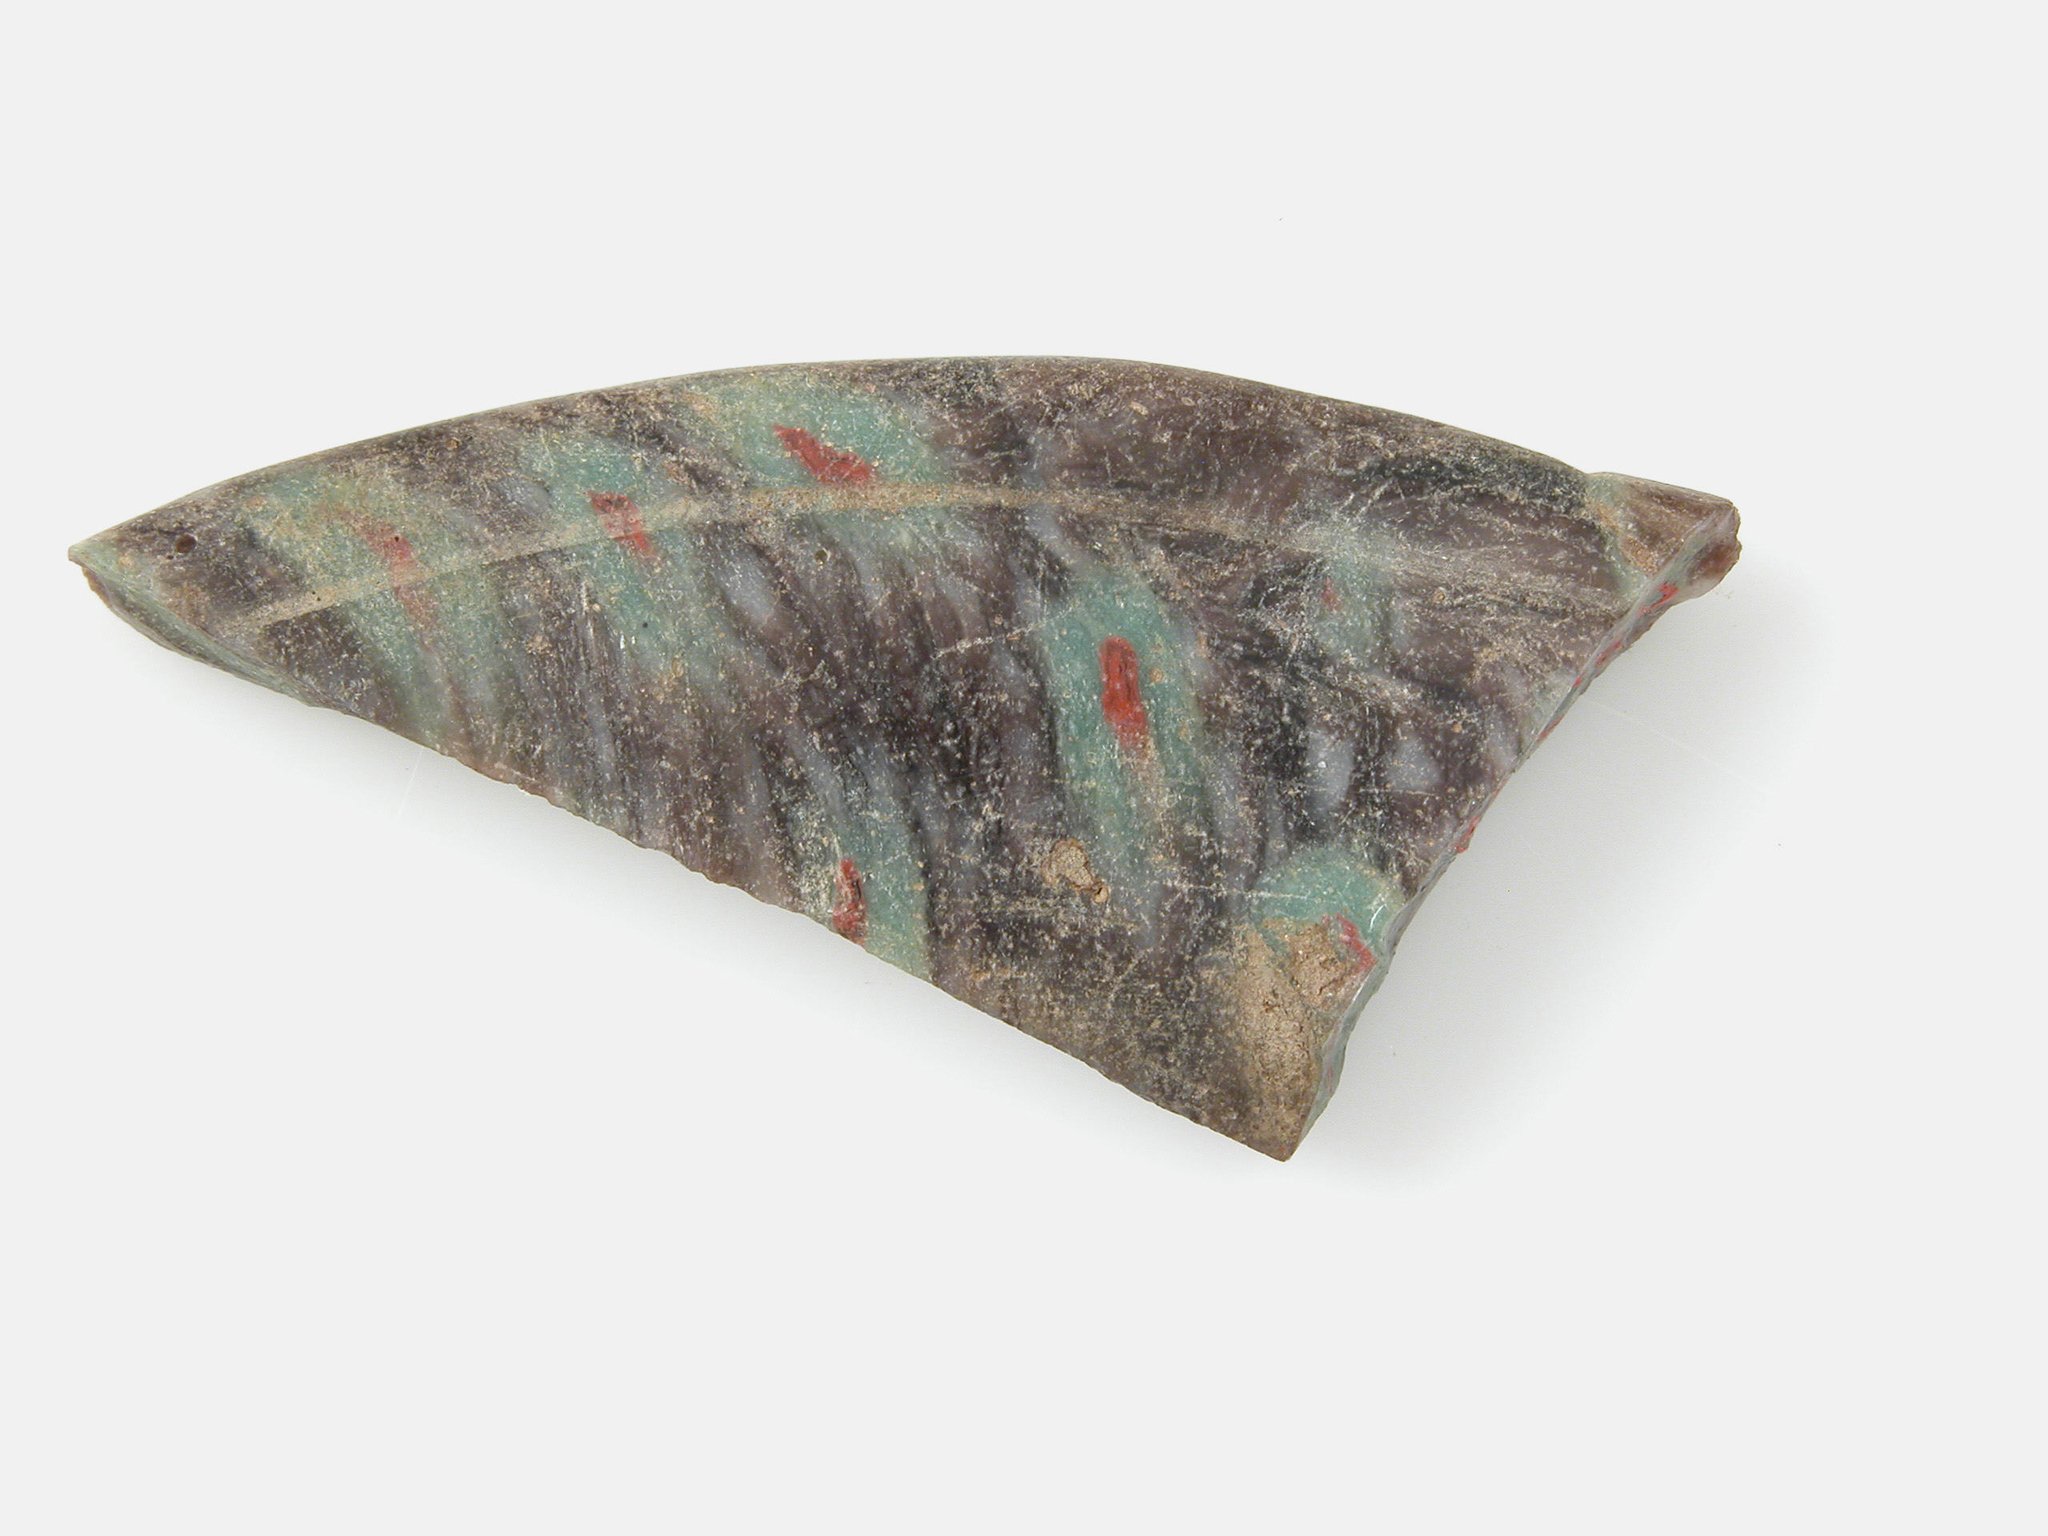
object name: fragment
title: Glass Fragment from a Vessel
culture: coptic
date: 301-433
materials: glass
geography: egypt